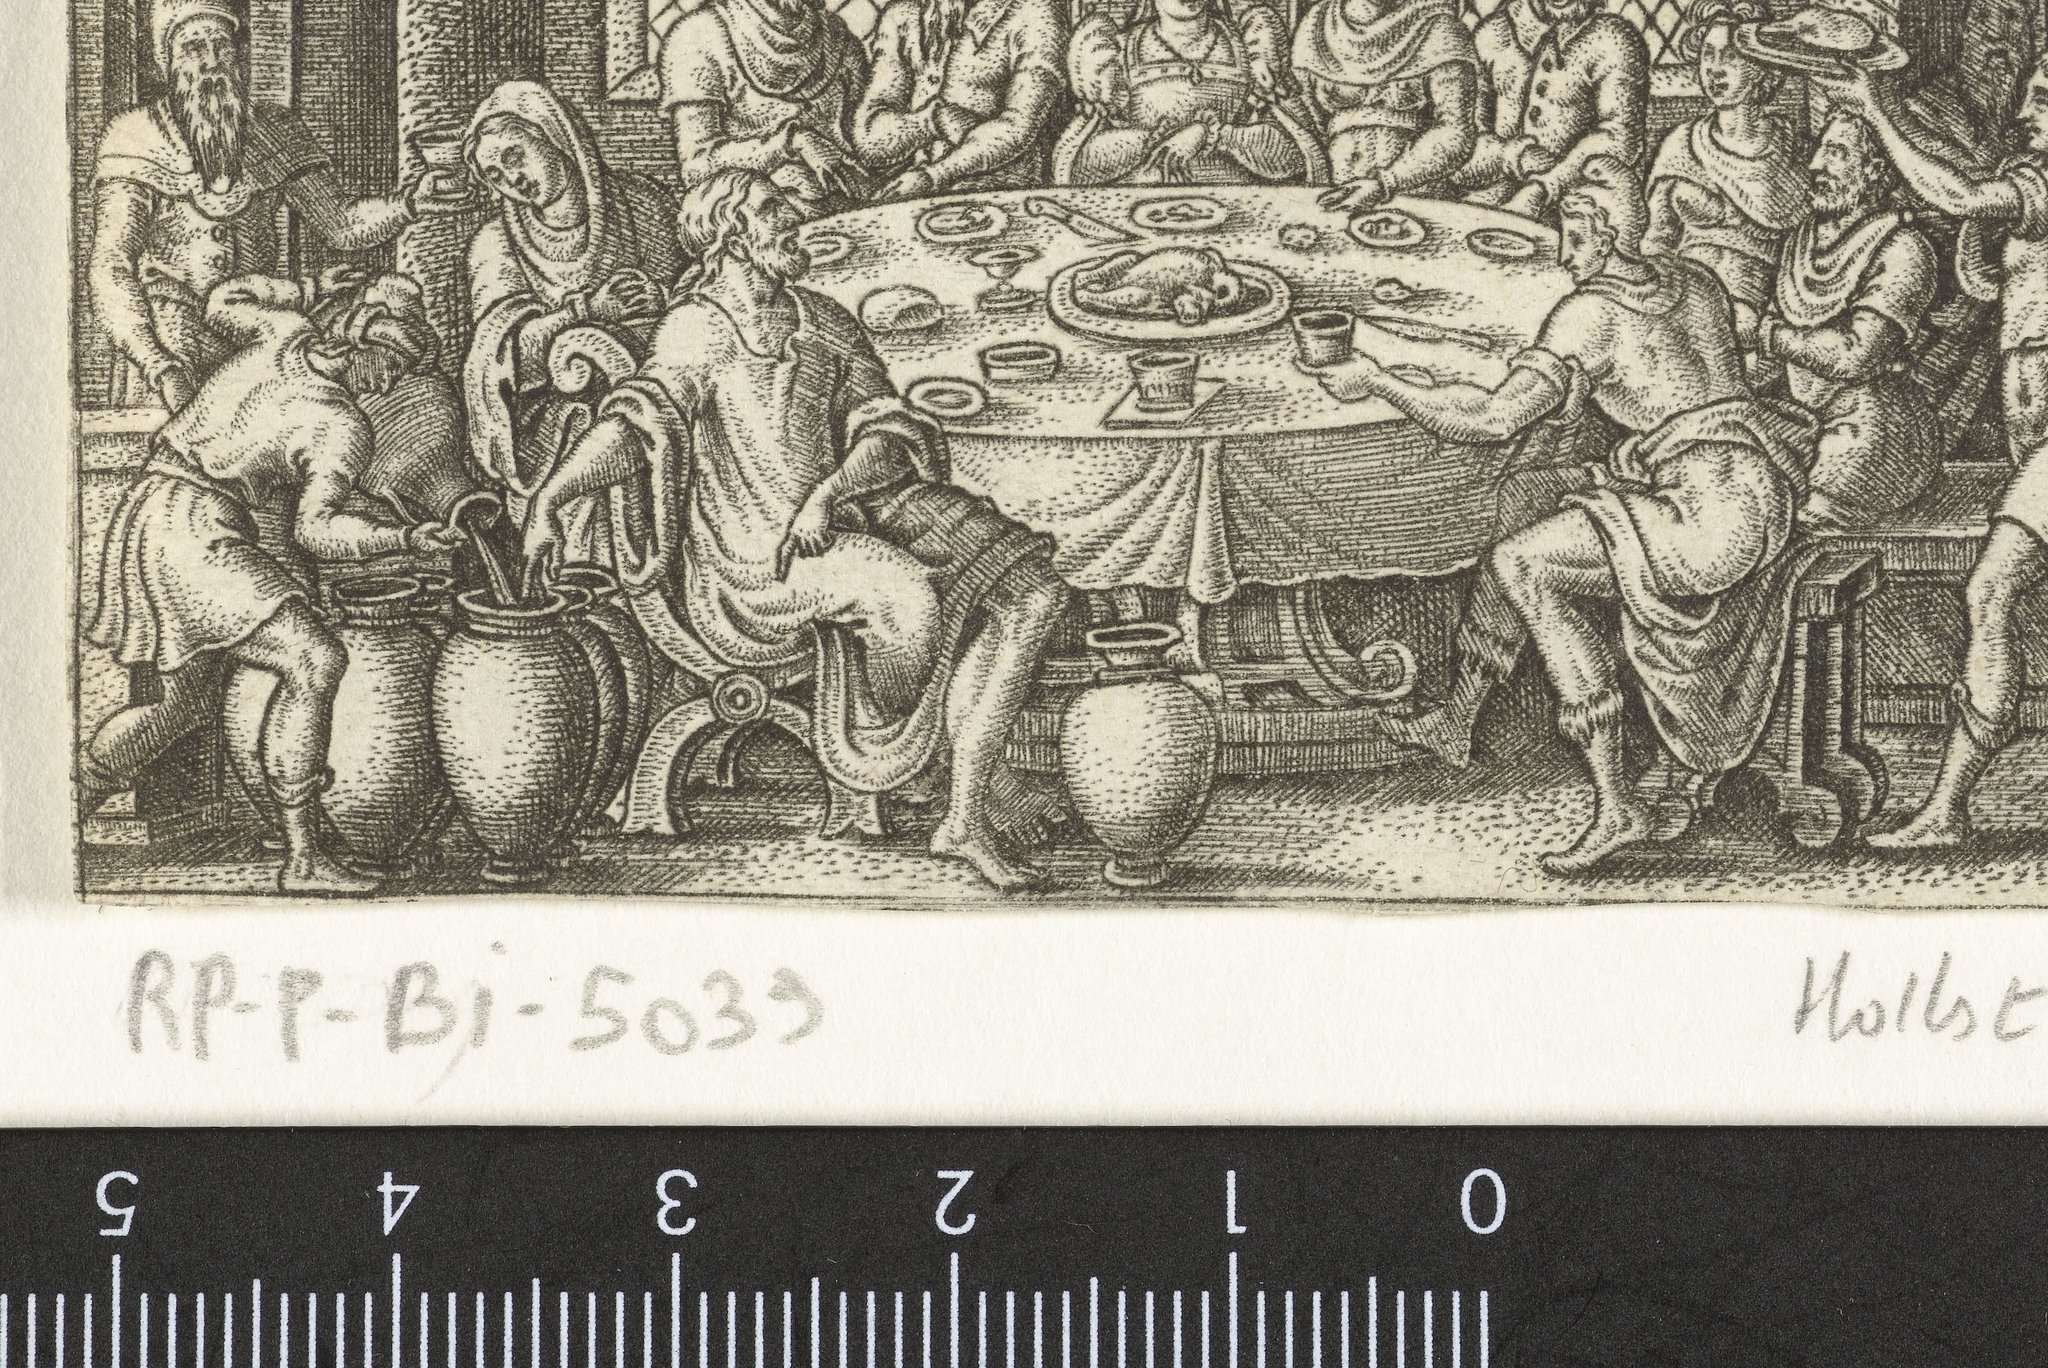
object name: print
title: Bruiloft te Kana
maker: abraham de bruyn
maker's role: print maker, publisher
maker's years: 1540-1587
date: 1550-1587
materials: paper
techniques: engraving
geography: antwerp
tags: the marriage-feast at cana (john 2:1-11)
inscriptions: date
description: De bruiloft te Kana. Rond een tafel zitten allerlei gasten te eten en te drinken. Aan het hoofd van de tafel zit de bruid met een kroontje op haar hoofd. Links giet een man water in een kruik. Christus zit links vooraan en wijst naar deze kruik. Zo verandert hij water in wijn en verricht hij een van zijn eerste wonderen (Johannes 2:1-12)